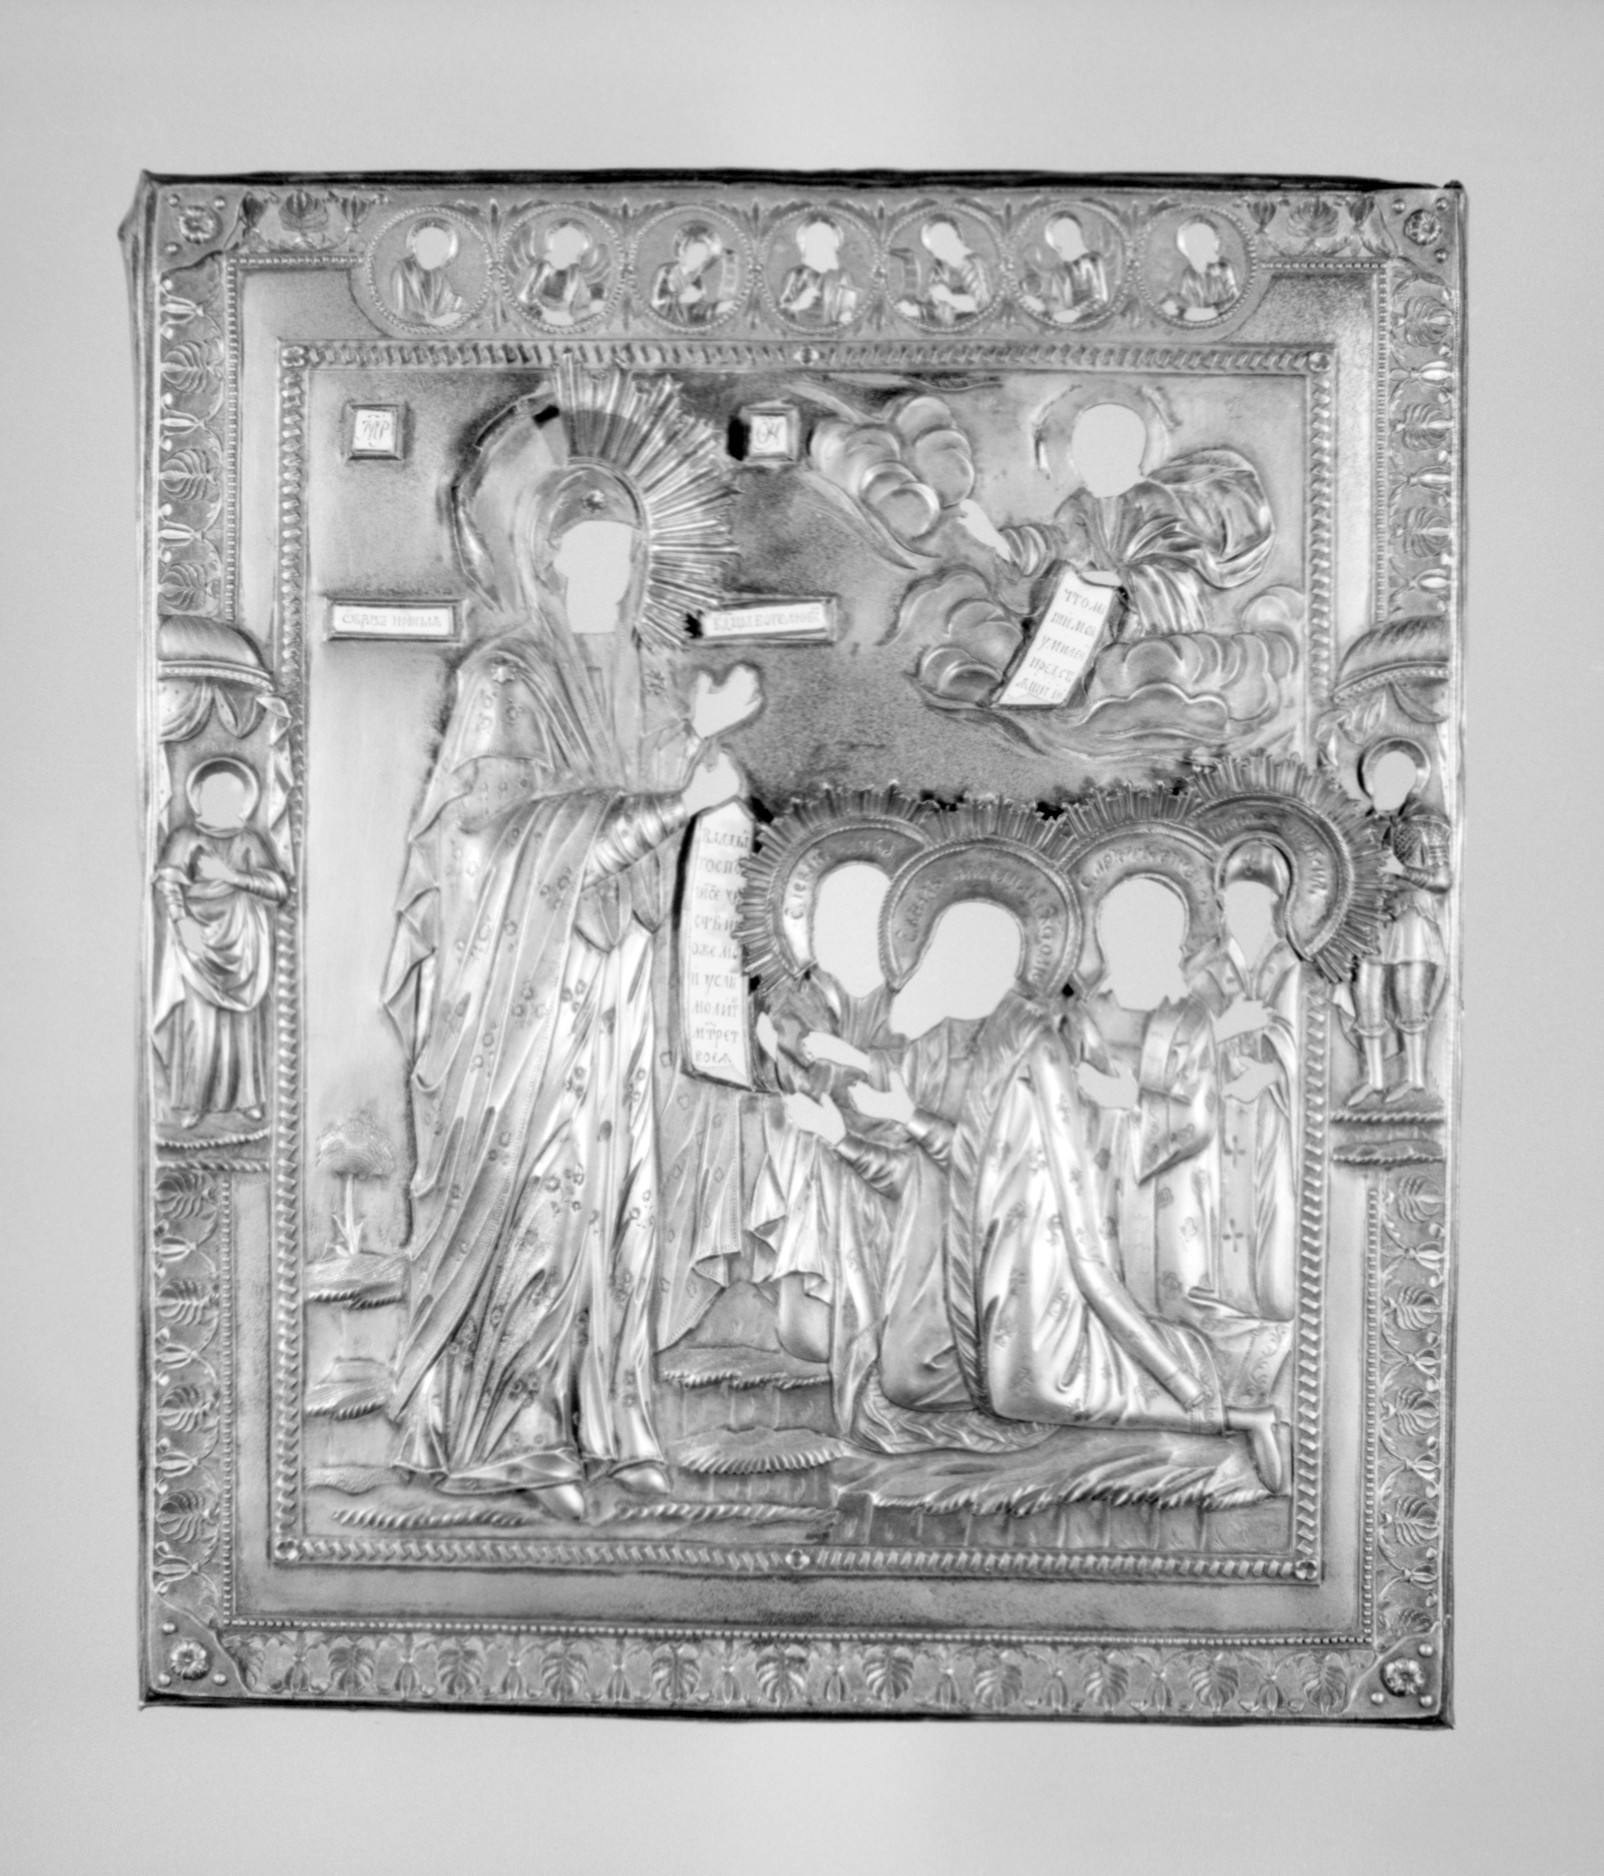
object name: icon cover and frame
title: Icon cover and frame (Riza) with Bogoliubskaya Mother of God with the Chosen Saints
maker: ph. phralov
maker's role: maker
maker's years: 1775-1875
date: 1815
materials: enamel, silver gilt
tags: virgin mary,saints